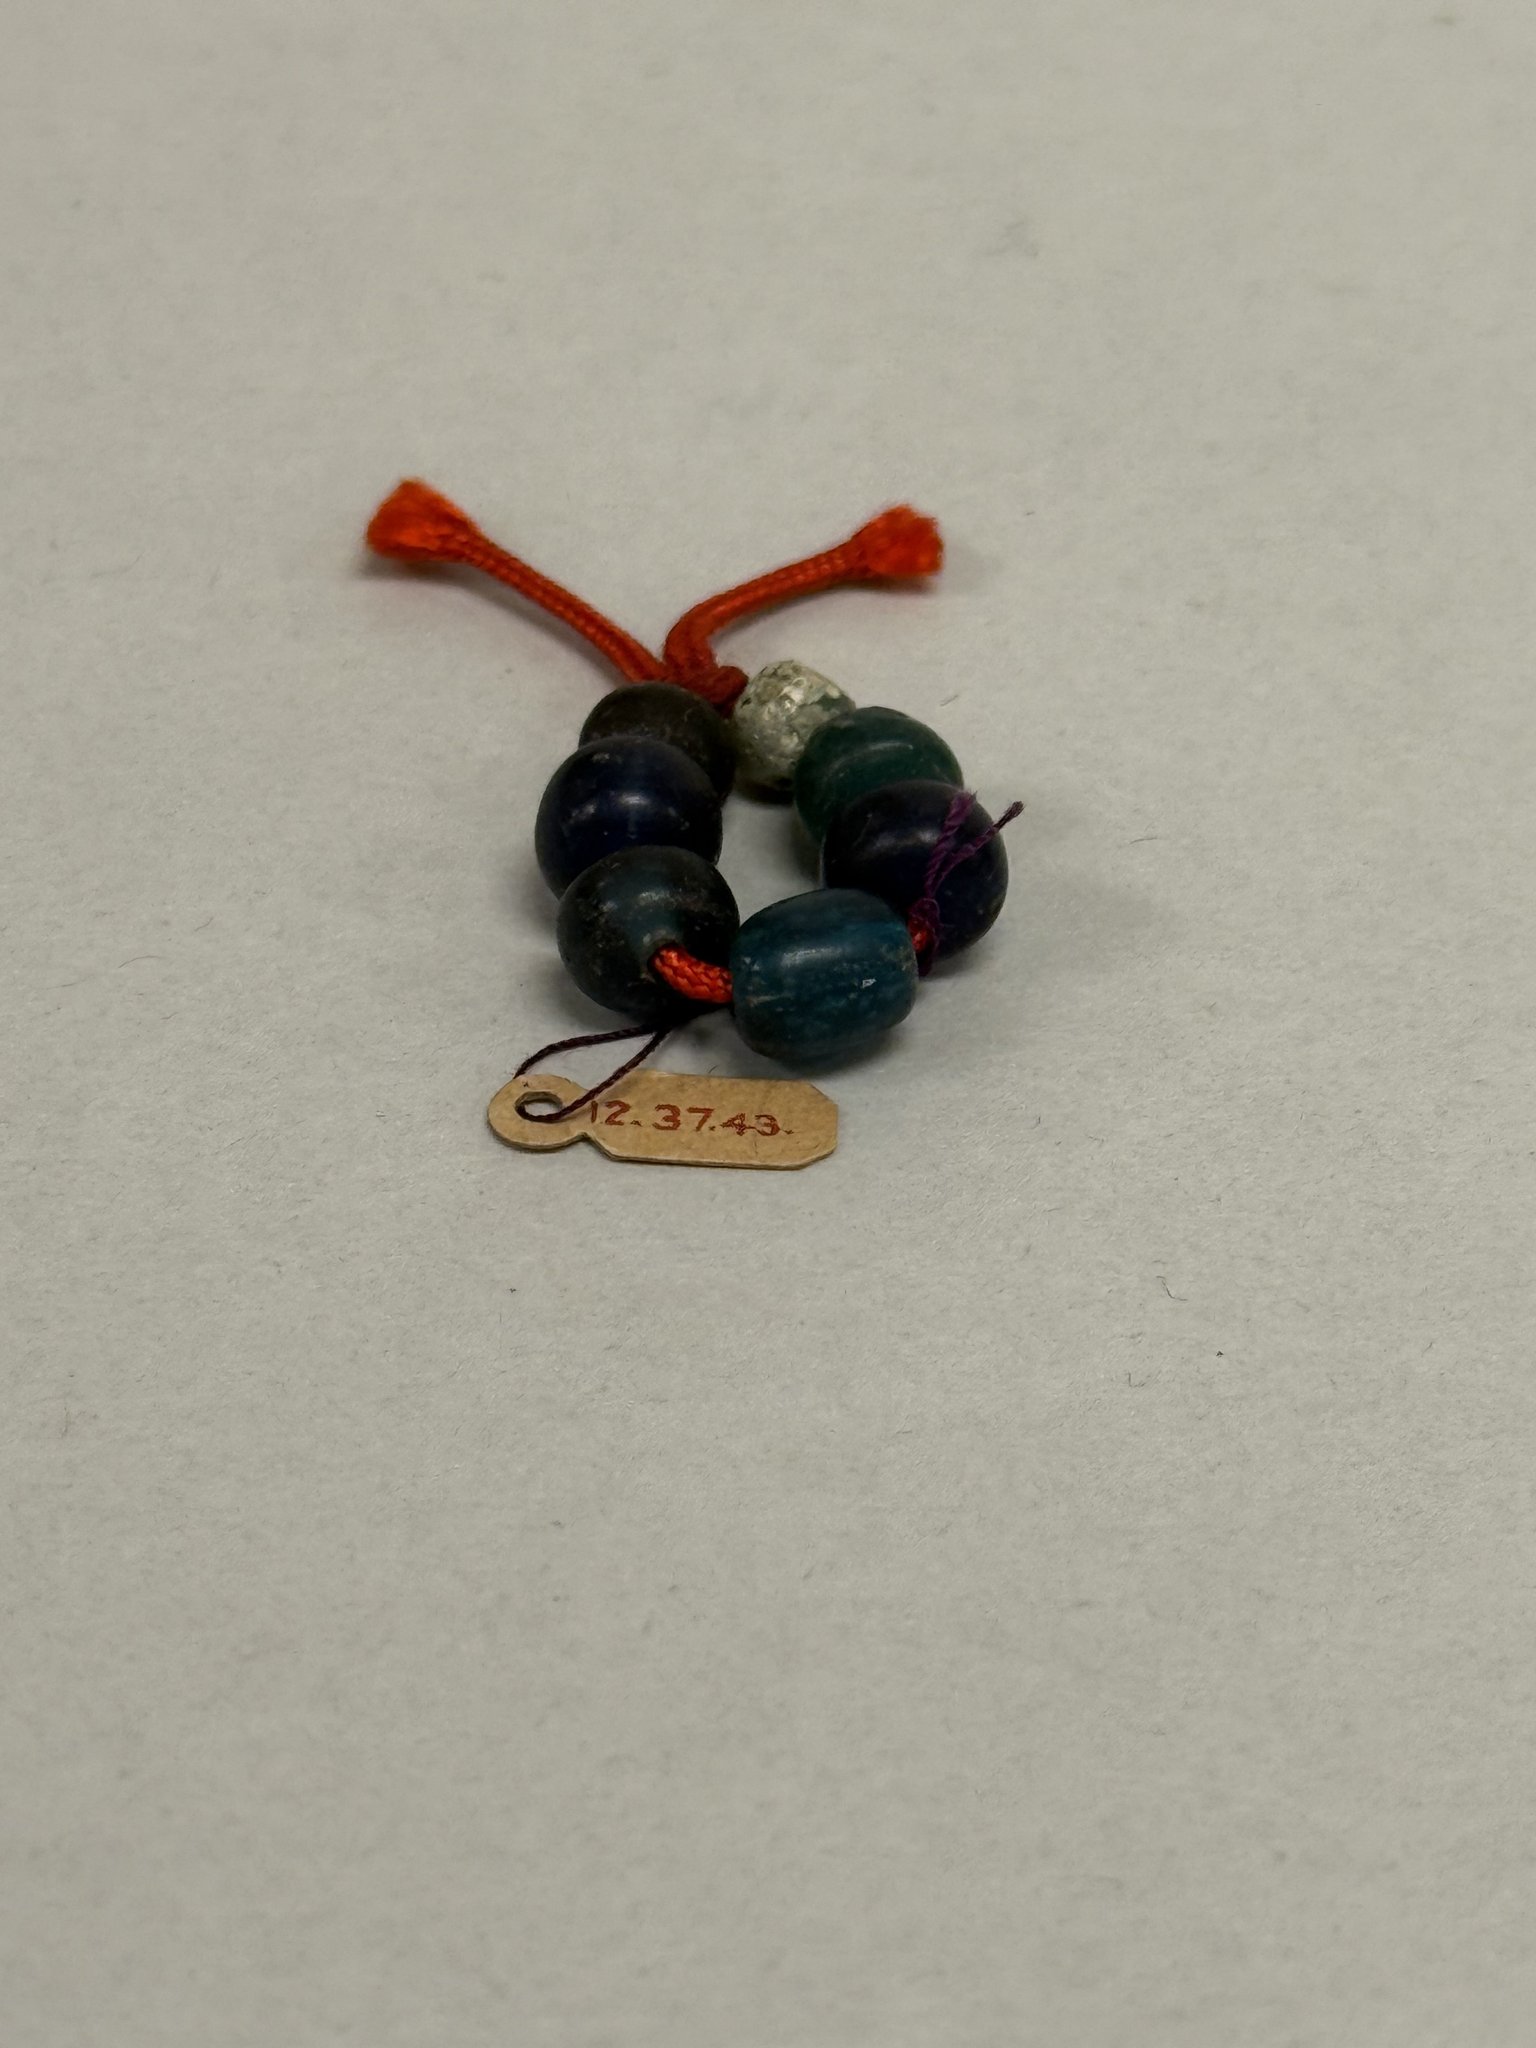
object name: bead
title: Beads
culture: japanese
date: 601-700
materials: glass, lacquer